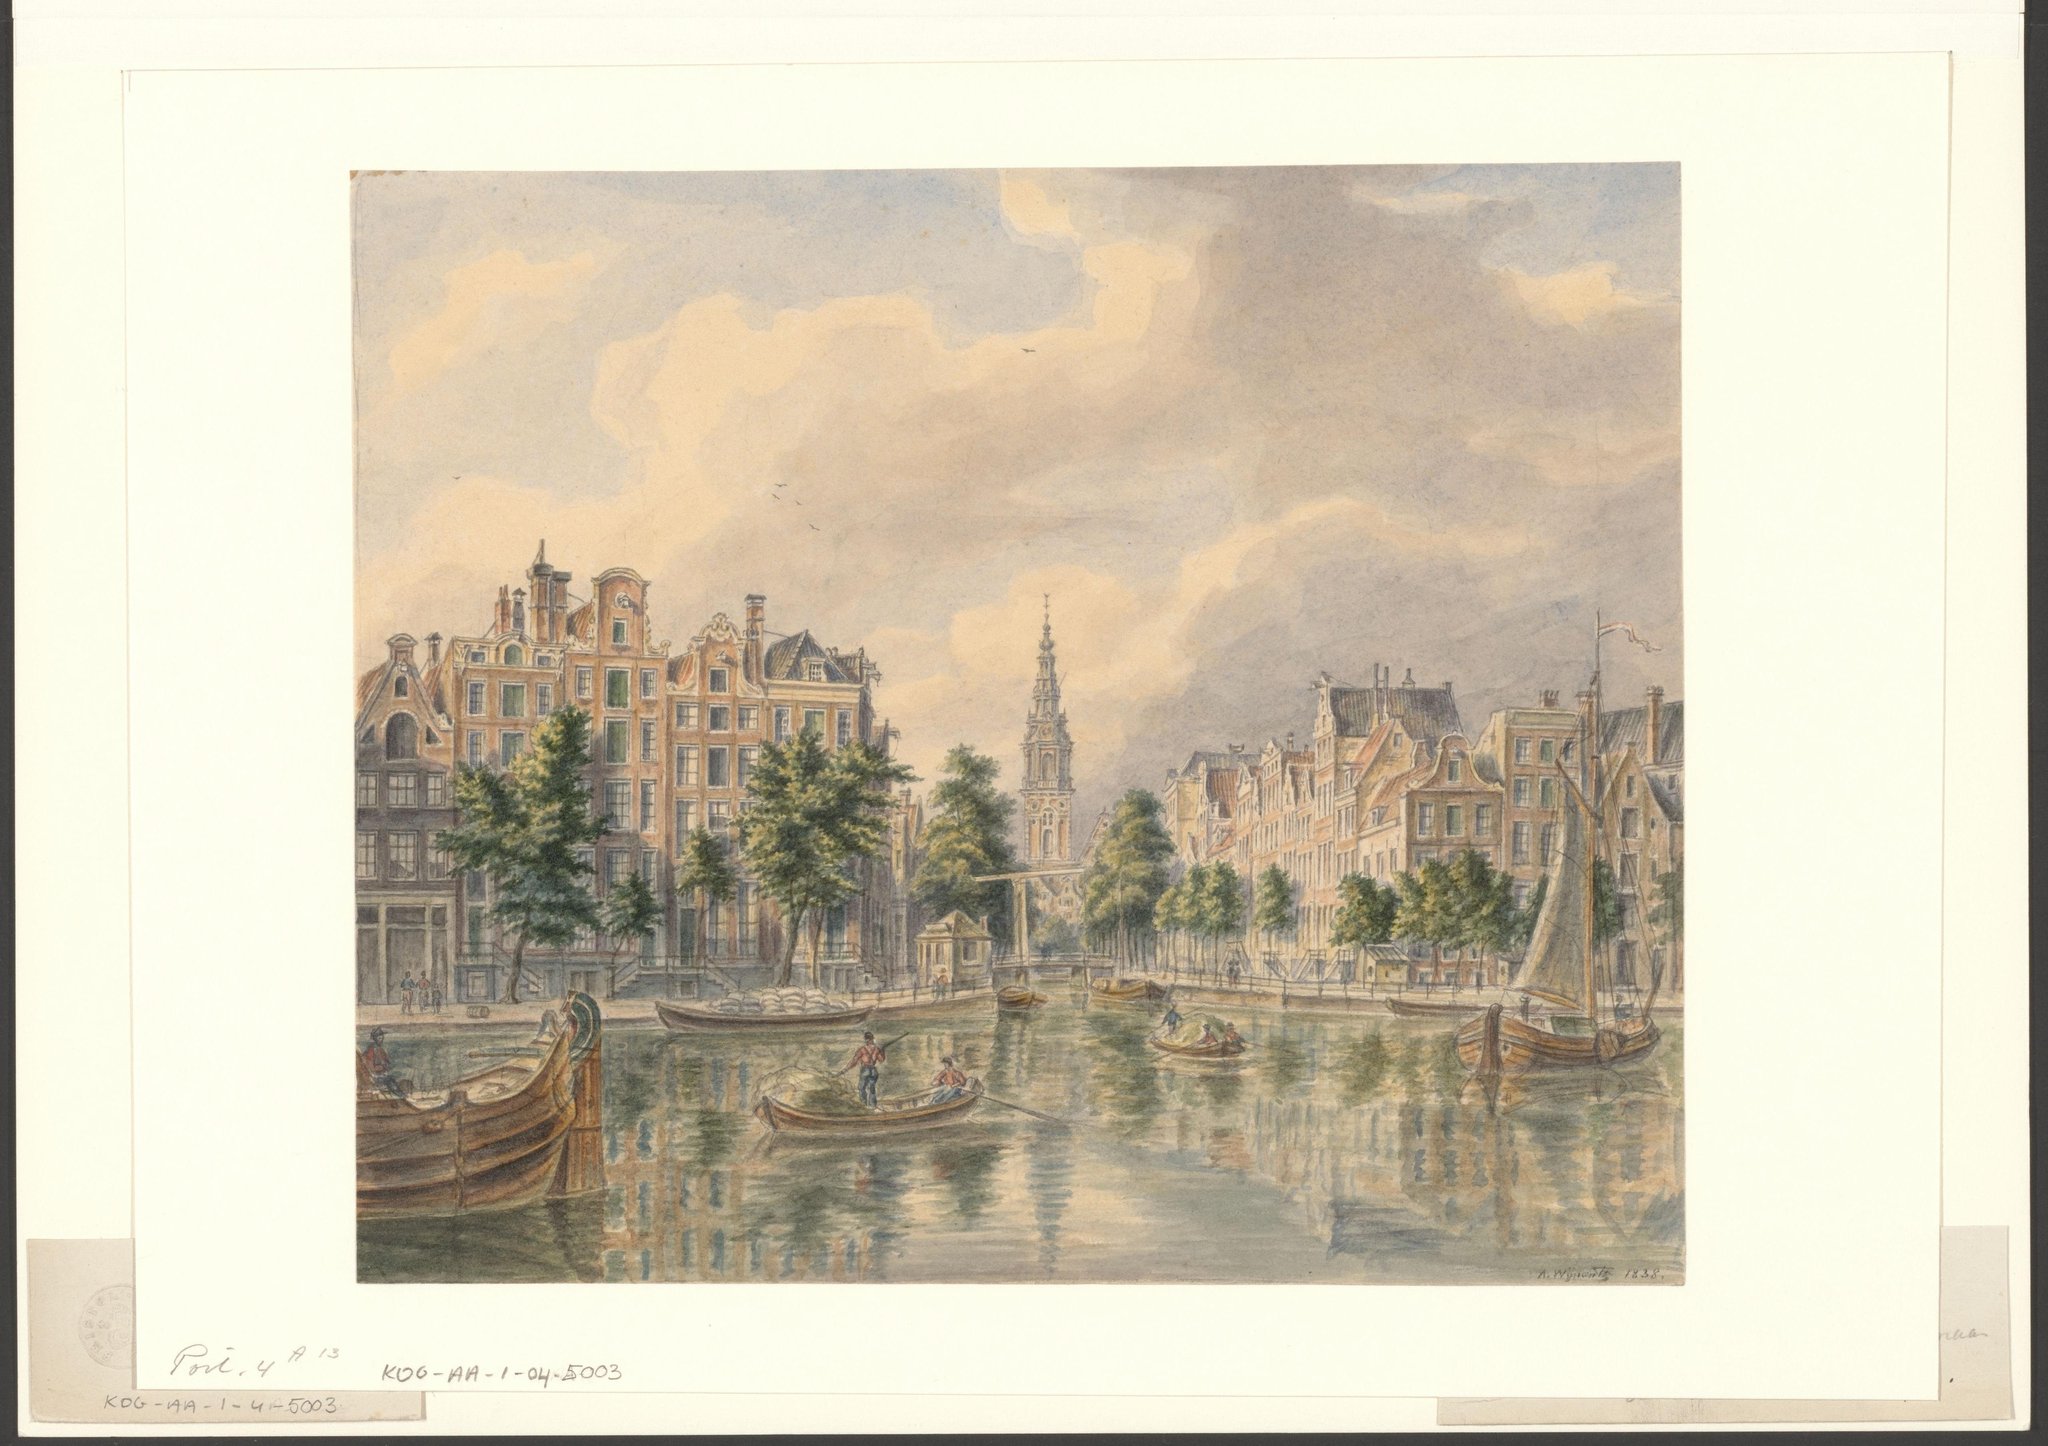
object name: drawing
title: Gezicht op het 's-Gravelandseveer met zicht over de Groenburgwal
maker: augustus wijnantz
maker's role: draughtsman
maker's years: 1795-1848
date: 1838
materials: ink, paper, pencil, watercolor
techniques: brush, pen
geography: amsterdam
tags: tower, clock tower ~ monumental adornment, city-view in general; 'veduta', canal, street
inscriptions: inscription: ‘32 / s Gravelandsche Veer’, collector's mark: ‘4A’ Lugt 1641b, inscription: ‘'s Gravelandsche veer (...) naar / de Zuiderkerkstoren’, signature and date: ‘A.Wijnantz 1838.’, inscription: ‘Port. 4A13’, check stamp: ‘Bristol / Board’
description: Onderwerpsrubriek binnen de Atlas Amsterdam: Amstel van Doelensluis tot Blauwbrug.